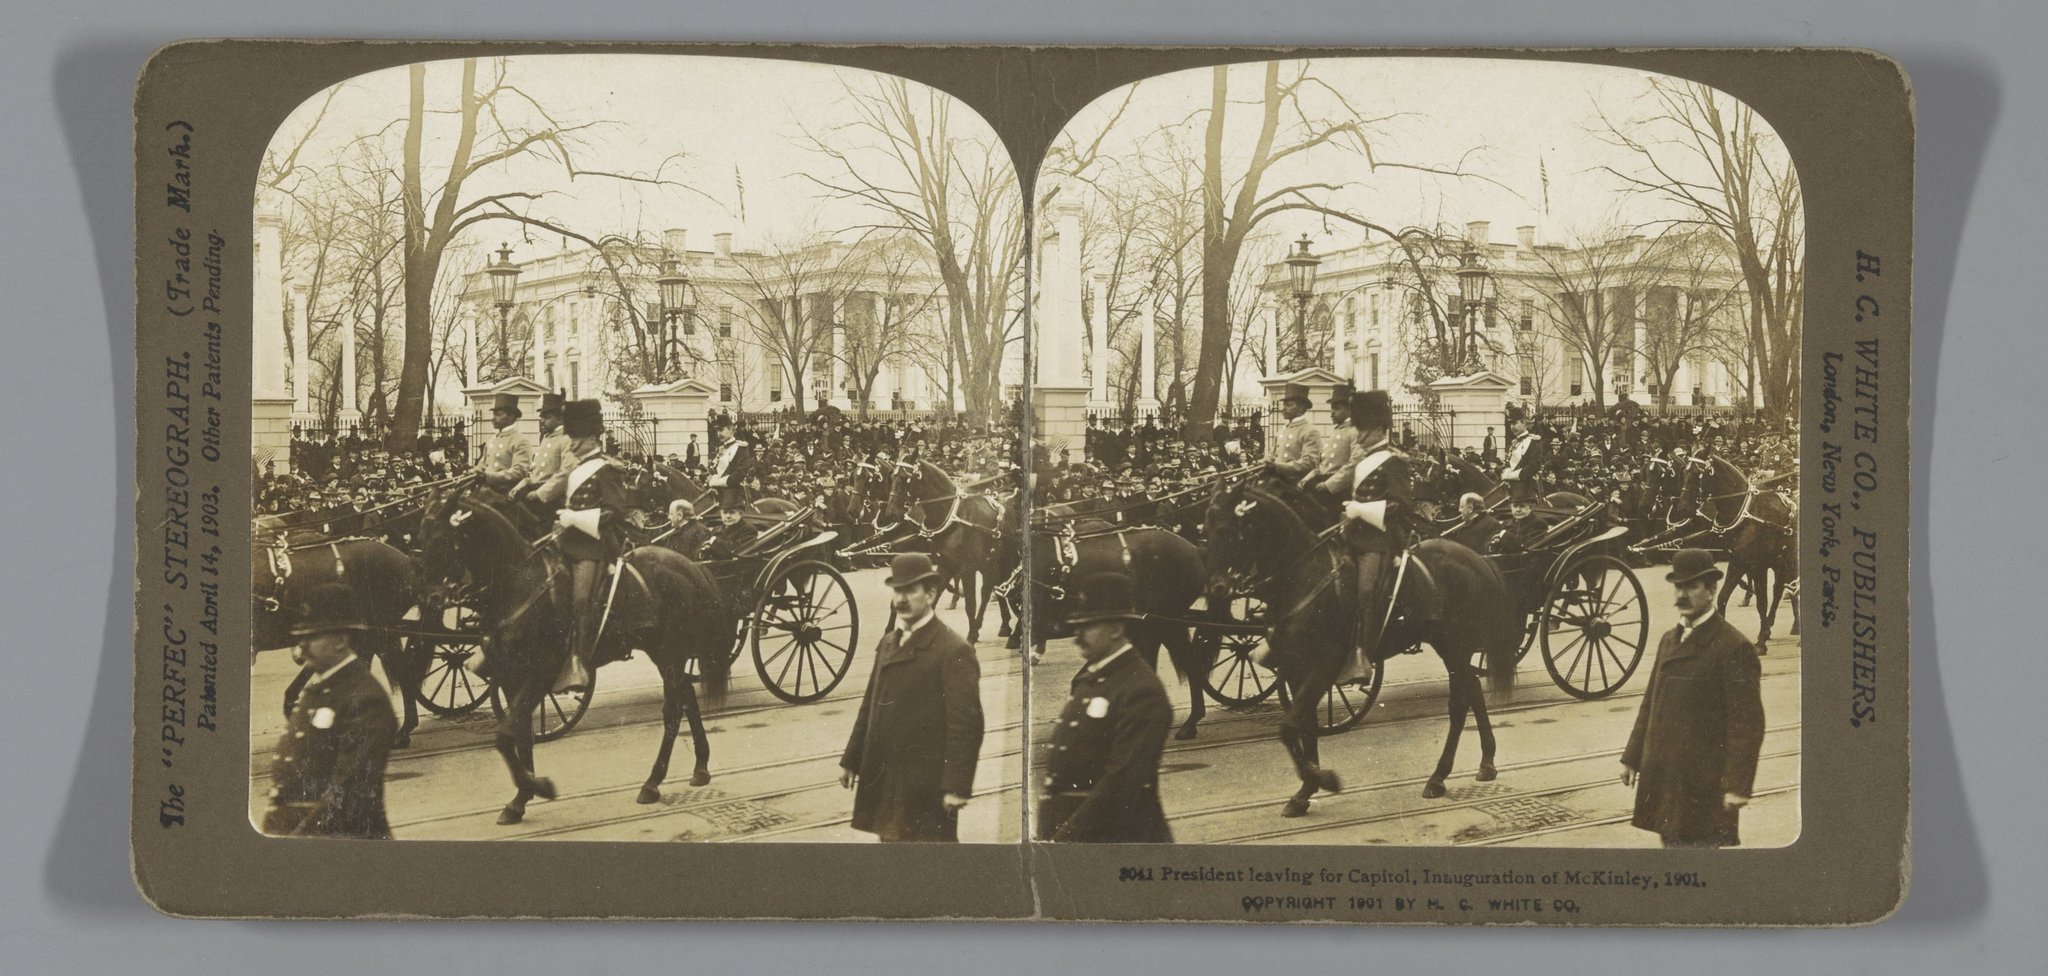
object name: stereograph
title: President leaving for Capitol, Inauguration of McKinley, 1901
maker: Anonymous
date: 1901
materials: paper, cardboard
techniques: gelatin silver print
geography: new york city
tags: ceremonial procession, parade, pageant ~ installation of a ruler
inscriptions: number: ‘3041’, copyright notice: ‘Copyright 1901 by H. C. White Co.’, inscription: ‘The " PERFEC" STEREOGRAPH. (Trade Mark.)/ Patented April 14, 1903. Other Patents Pending.’